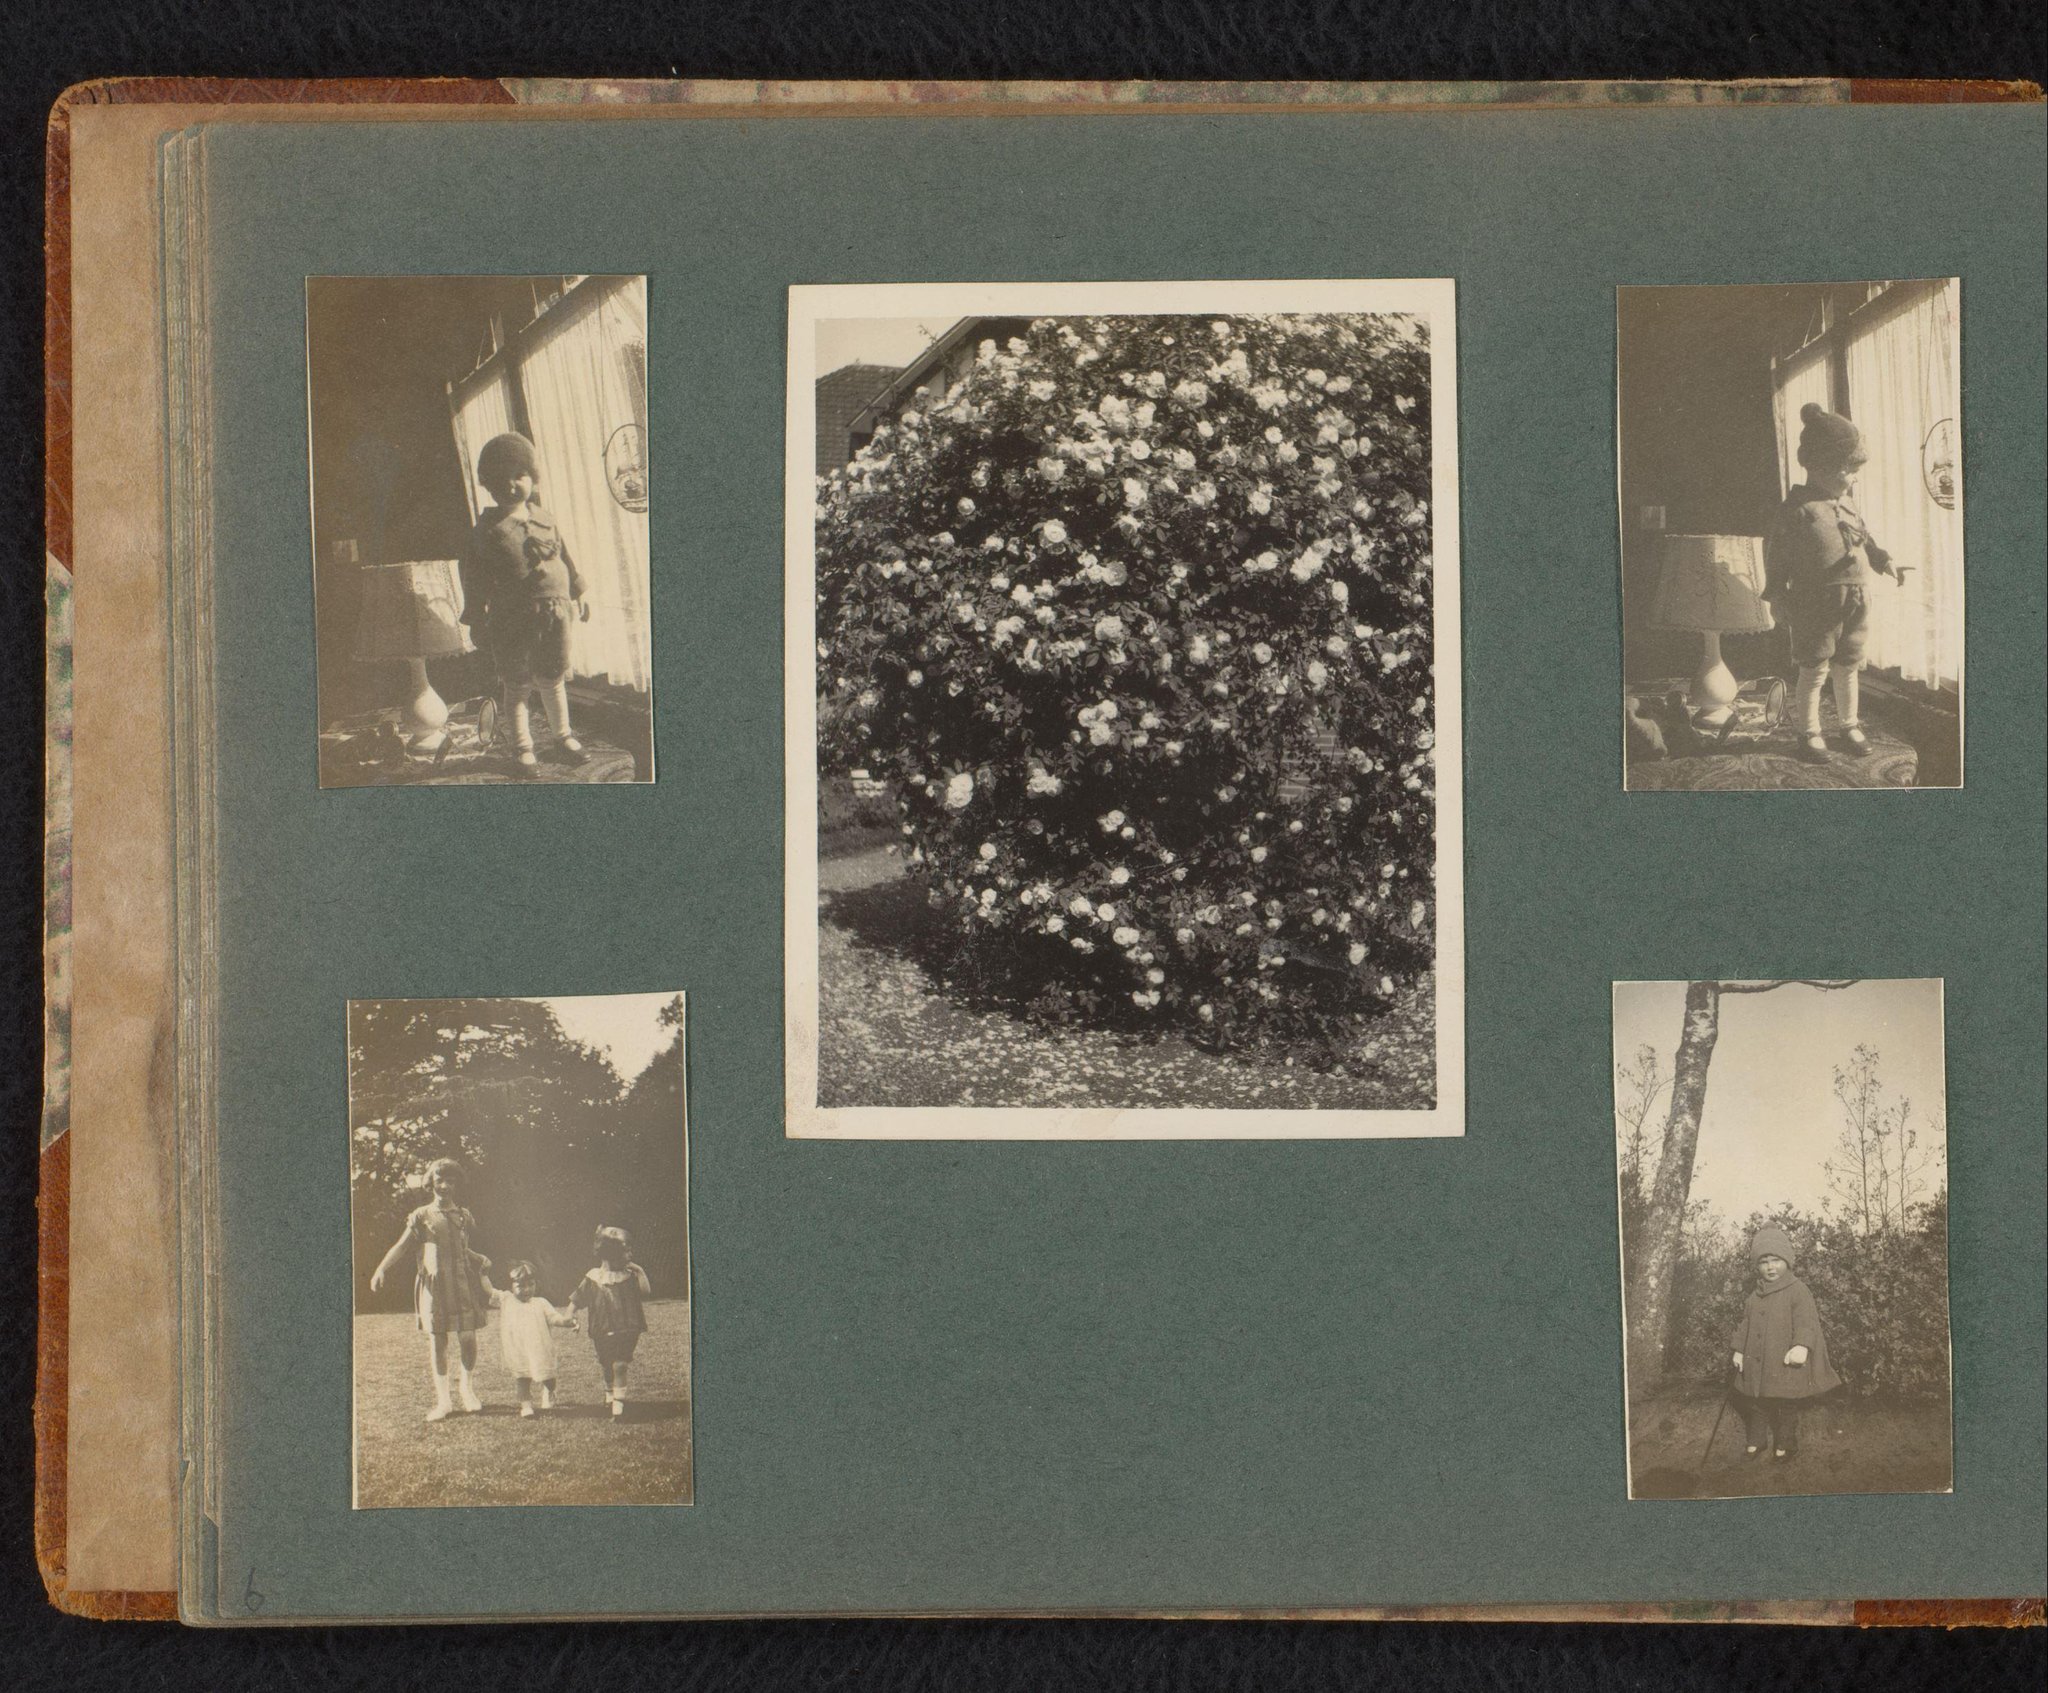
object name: album leaf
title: Vijf foto's van kinderen van familie Onnen-Van den Berg en een bloeiende rozenstruik aan de Kroonlaan in Hilversum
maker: Anonymous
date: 1920-1930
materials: paper, cardboard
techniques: gelatin silver print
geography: hilversum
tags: child, historical persons, shrubs: rose-bush, mother and baby or young child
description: Deze foto's maken deel uit van een album.